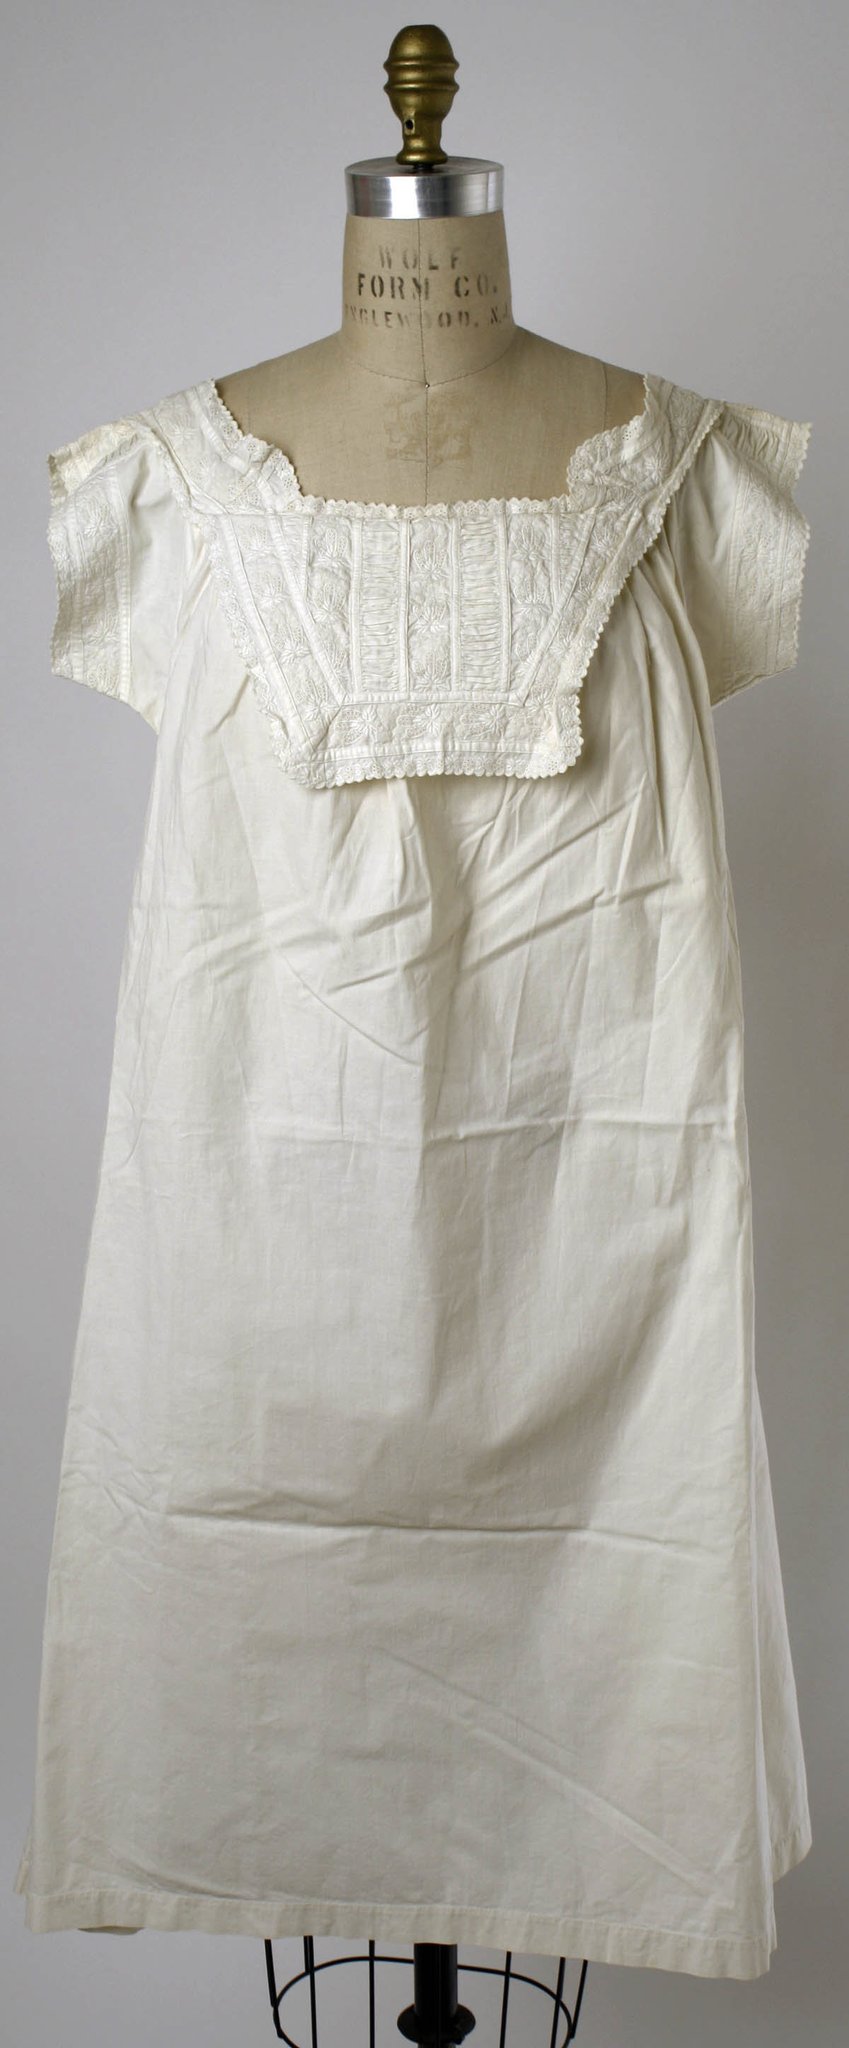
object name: chemise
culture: american or european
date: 1870-1879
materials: cotton